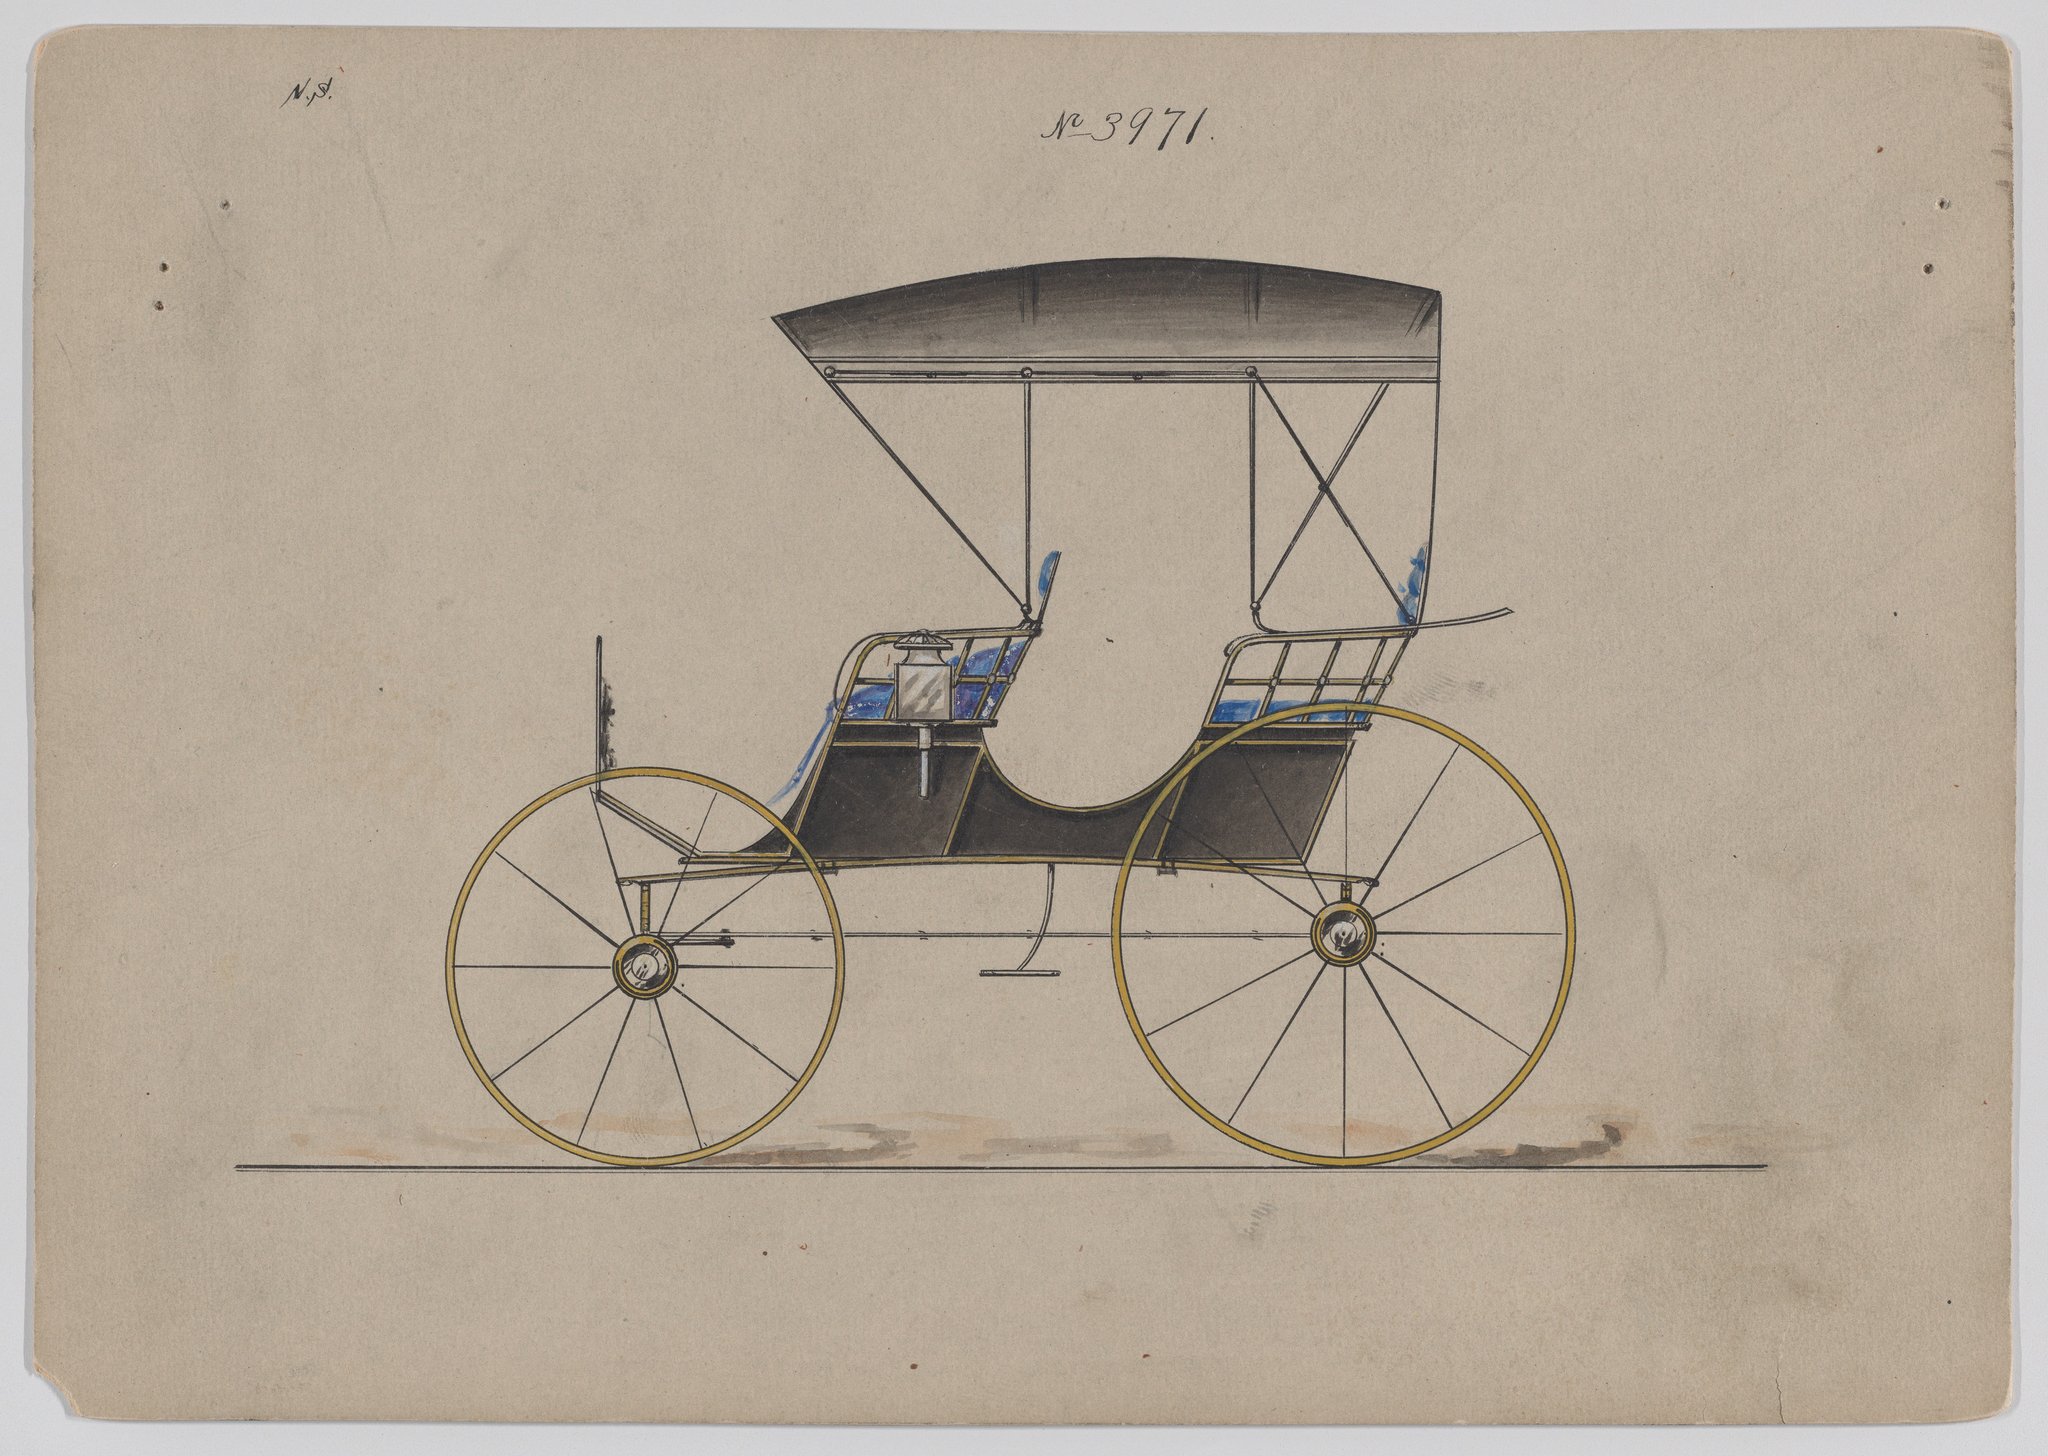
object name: drawing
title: Design for 2 seat Park Phaeton, no. 3971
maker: brewster & co.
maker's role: manufacturer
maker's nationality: american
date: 1886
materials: gouache, ink, watercolor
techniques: pen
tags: carriages